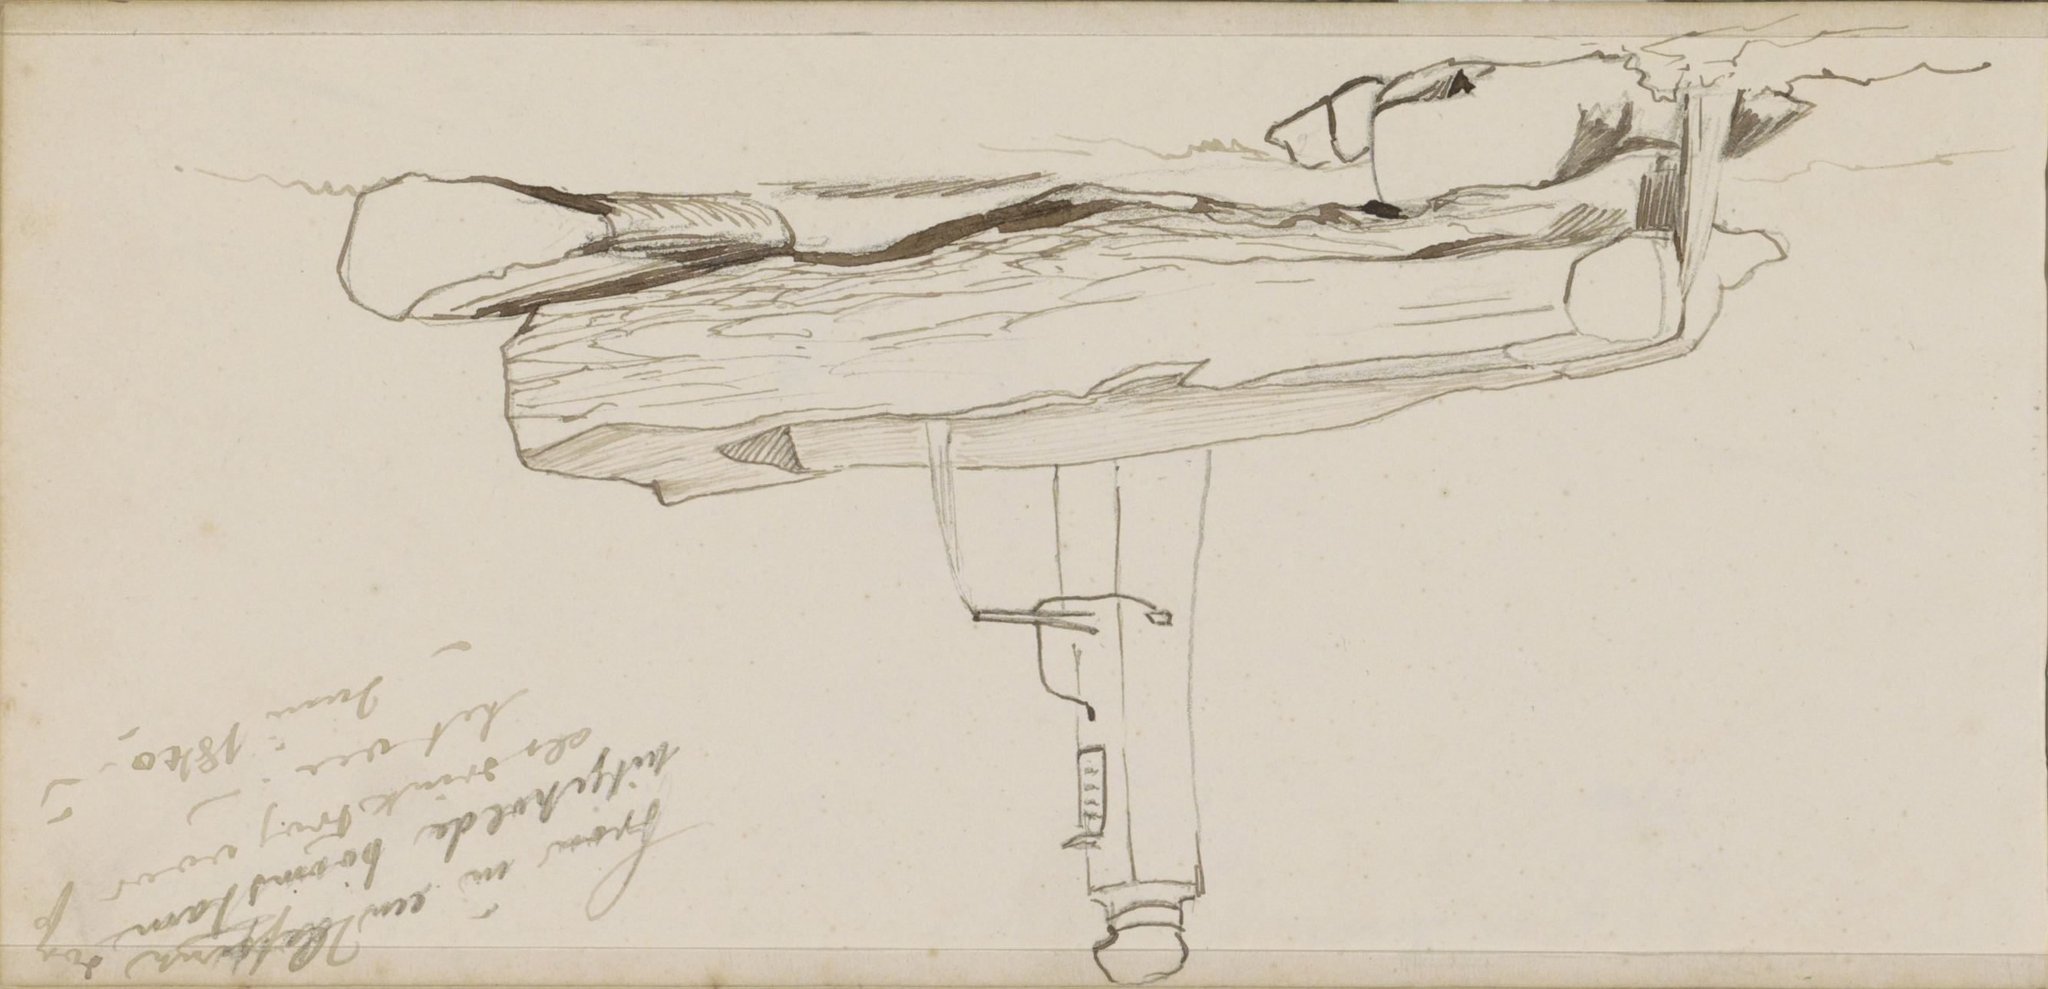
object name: sketchbook leaf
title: Uitgeholde boomstam als drinkbak voor vee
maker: johannes tavenraat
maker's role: draughtsman, painter, print maker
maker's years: 1809-1881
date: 1806-1840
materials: ink, paper, pencil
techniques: pen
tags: trough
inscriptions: date and inscription: ‘[...] in een [...]/ uitgeholde boomstam op/ als drink[...] voor het vee.-/ Juni 1840.-’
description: Blad 43 verso uit een schetsboek met 63 bladen.